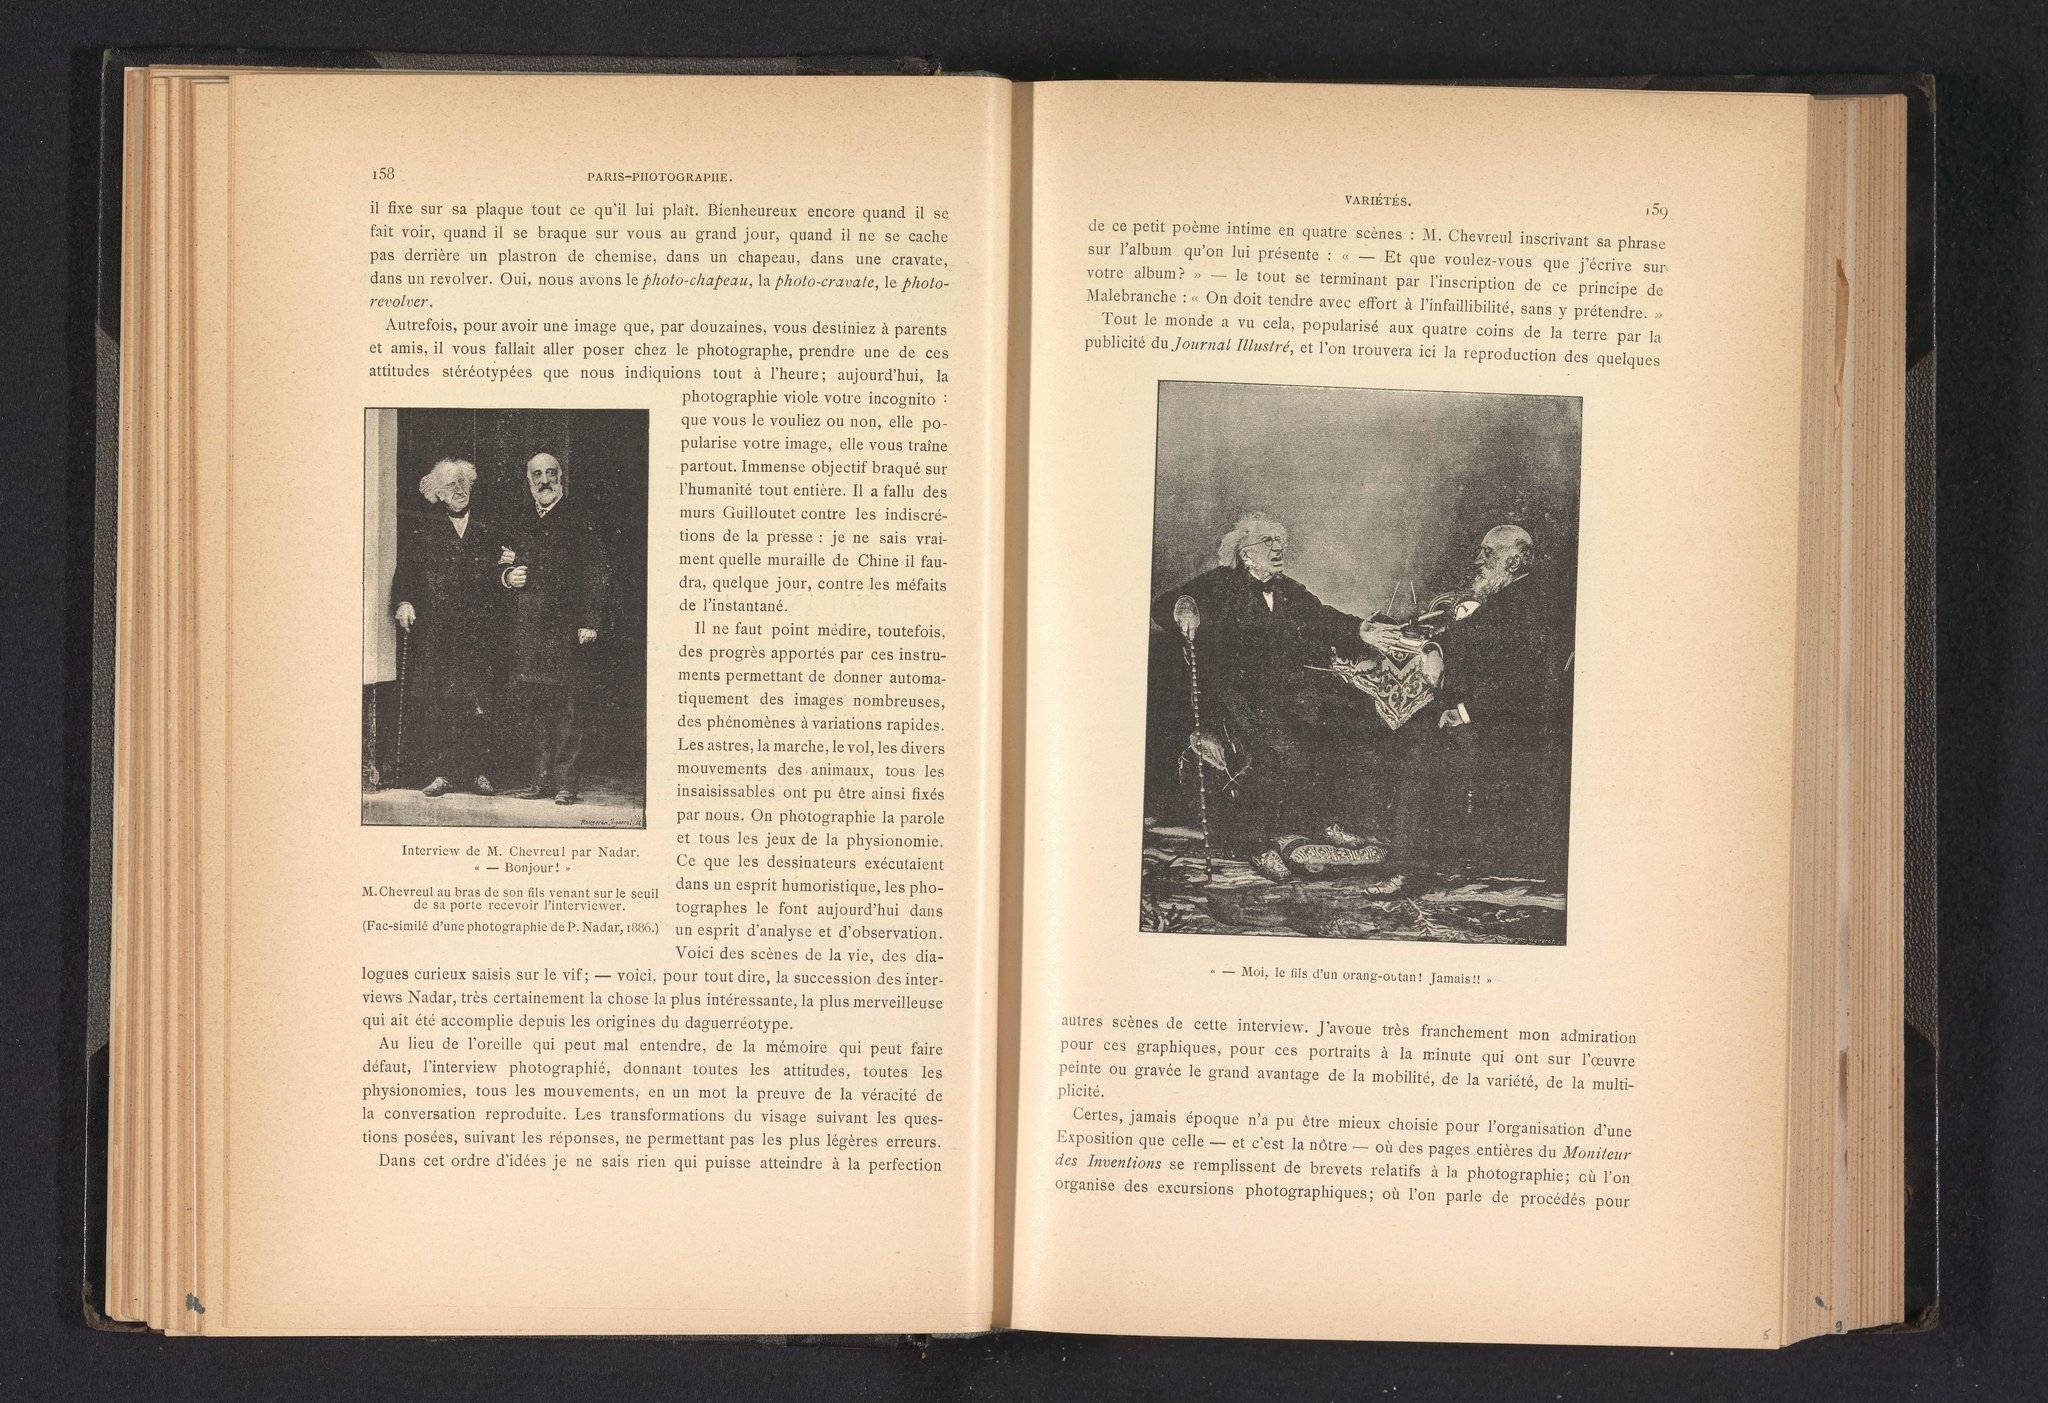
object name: page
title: Michel Eugène Chevreul en Paul Nadar gearmd voor een deur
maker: paul nadar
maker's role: fotograaf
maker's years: 1856-1939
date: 1886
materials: paper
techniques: autotype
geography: france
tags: paris, paul nadar, photographer in non-work situation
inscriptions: inscription: ‘M. Chevreul au bras de son fils venanr sur le seuil de sa porte de recevoir l'interviewer.’